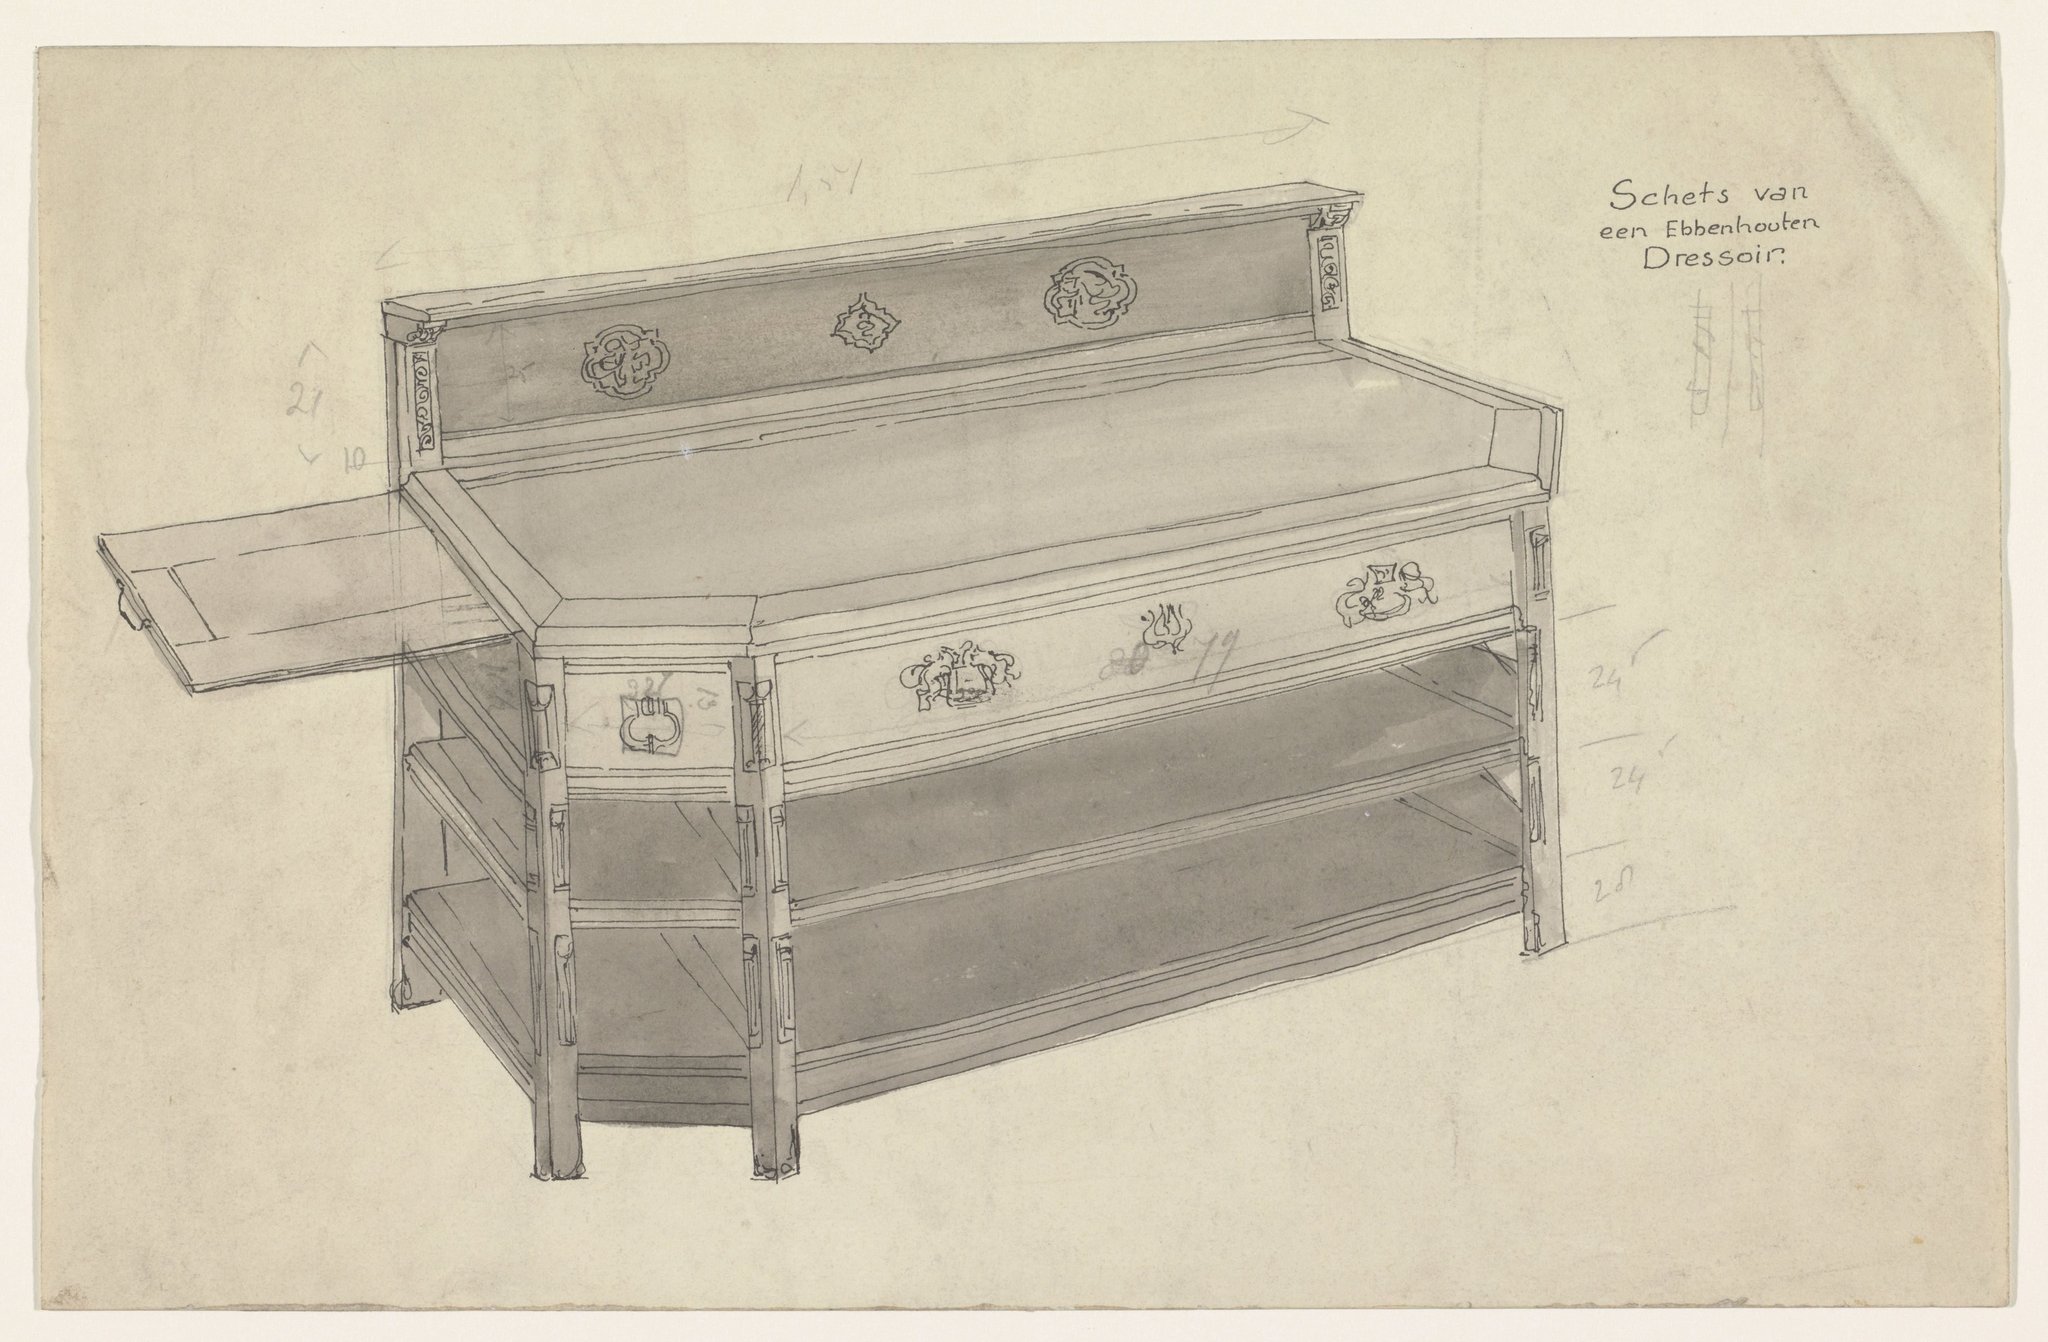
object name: design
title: Ontwerp voor een ebbenhouten dressoir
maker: carel adolph lion cachet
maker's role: draughtsman, print maker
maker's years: 1864-1945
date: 1874-1945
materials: ink, paper, pencil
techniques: brush, pen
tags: ornamental cupboard